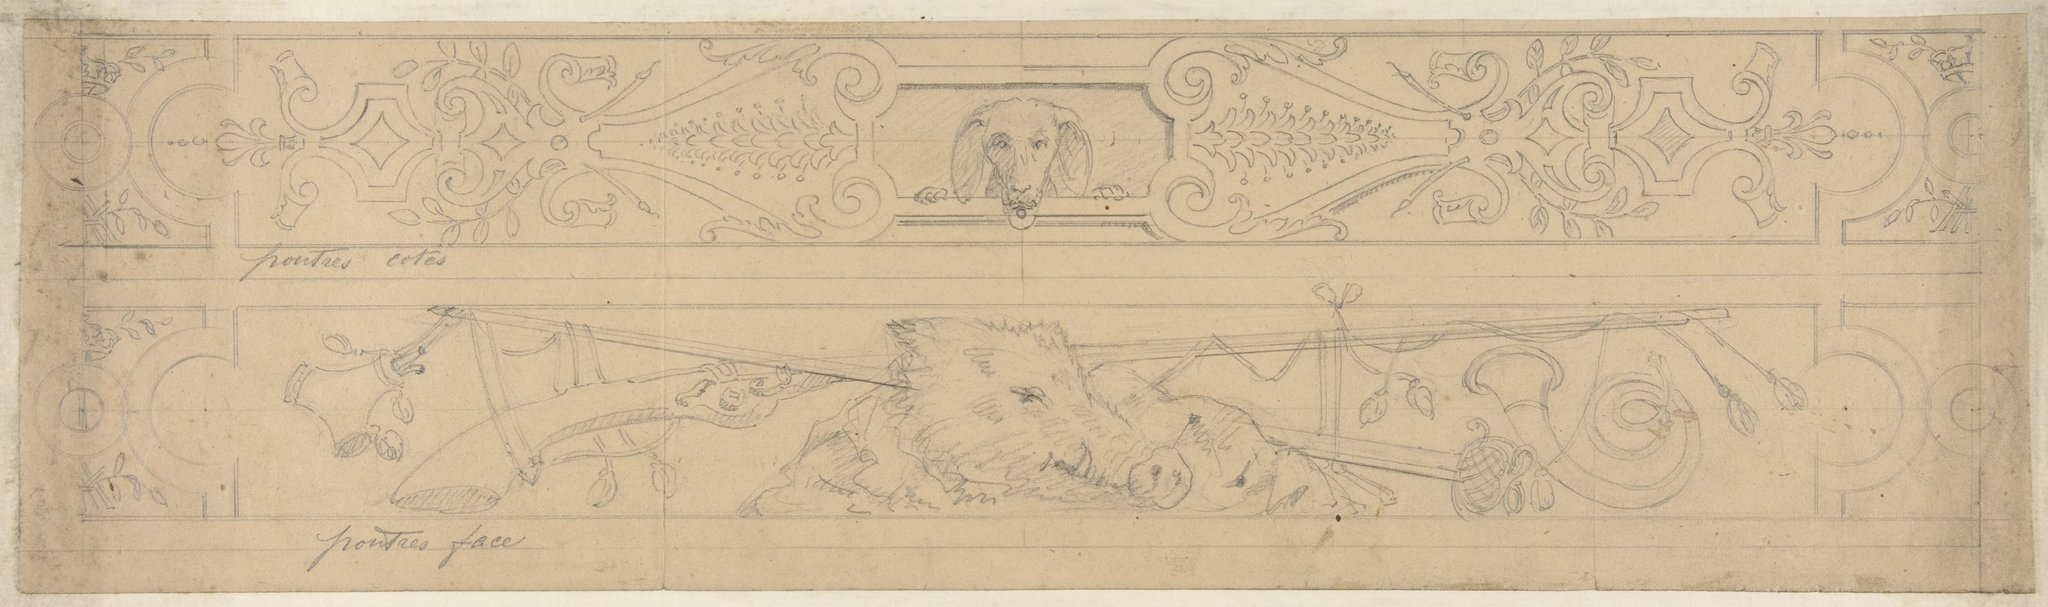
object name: drawing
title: Two designs for panels to decorate a hunting lodge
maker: jules-edmond-charles lachaise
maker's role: artist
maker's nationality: french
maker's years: 1897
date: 1830-1897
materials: graphite, paper